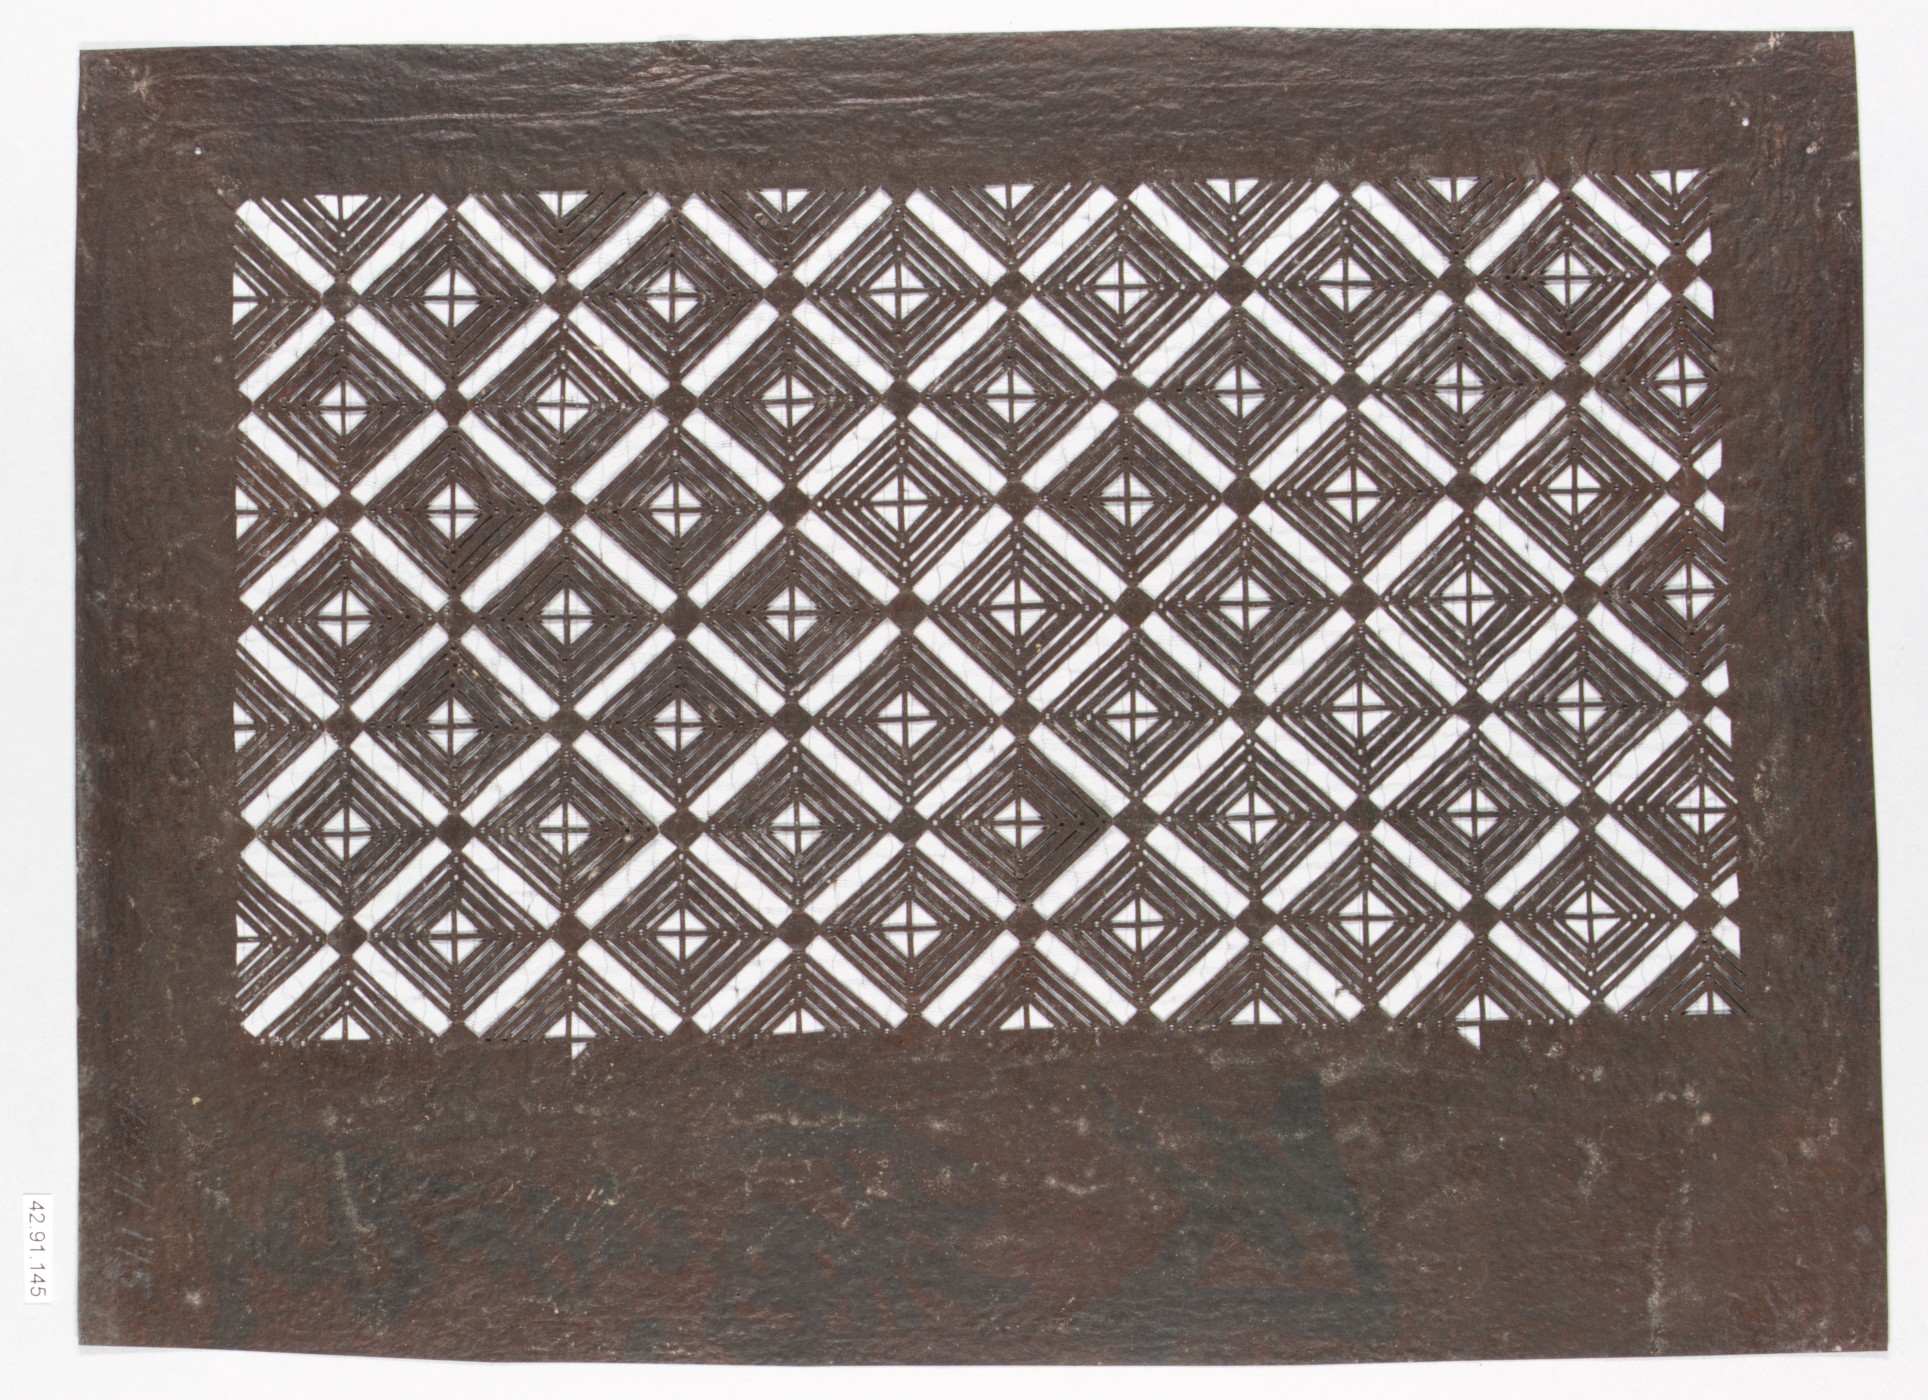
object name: stencil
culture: japanese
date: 1801-1900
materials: paper, silk